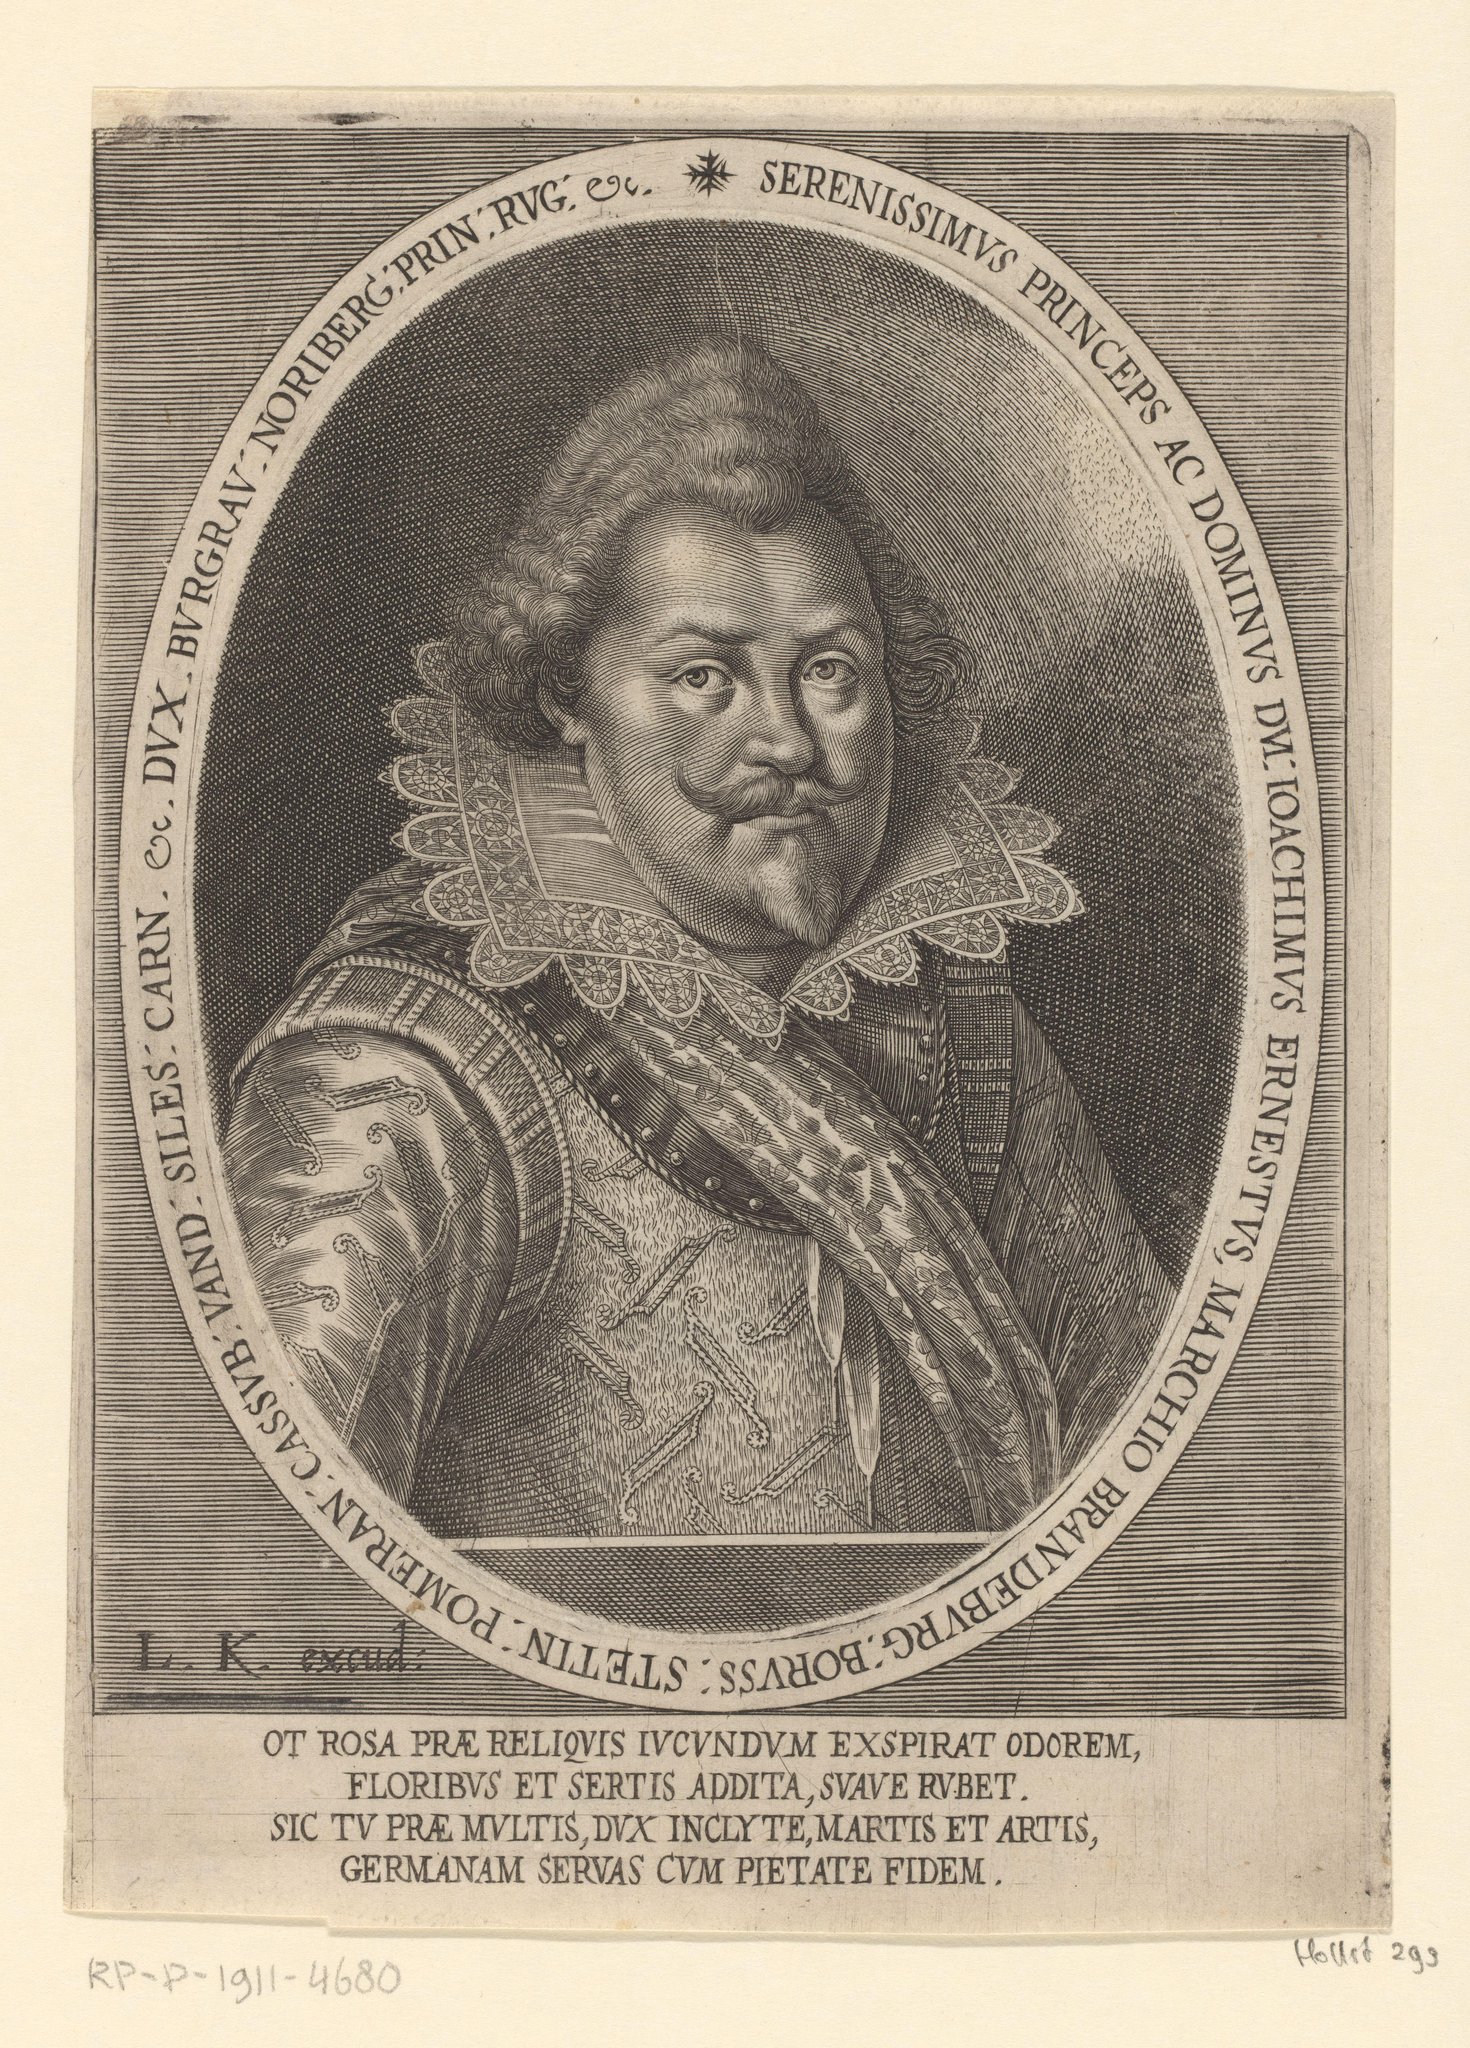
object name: print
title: Portret van Joachim Ernst von Brandenburg-Ansbach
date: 1603-1637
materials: paper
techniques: engraving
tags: joachim ernst von brandenburg-ansbach, historical persons, ambassador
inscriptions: collector's mark: Lugt 2228, collector's mark: Lugt 2228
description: Tekst in het Latijn in de omlijsting en in de ondermarge.